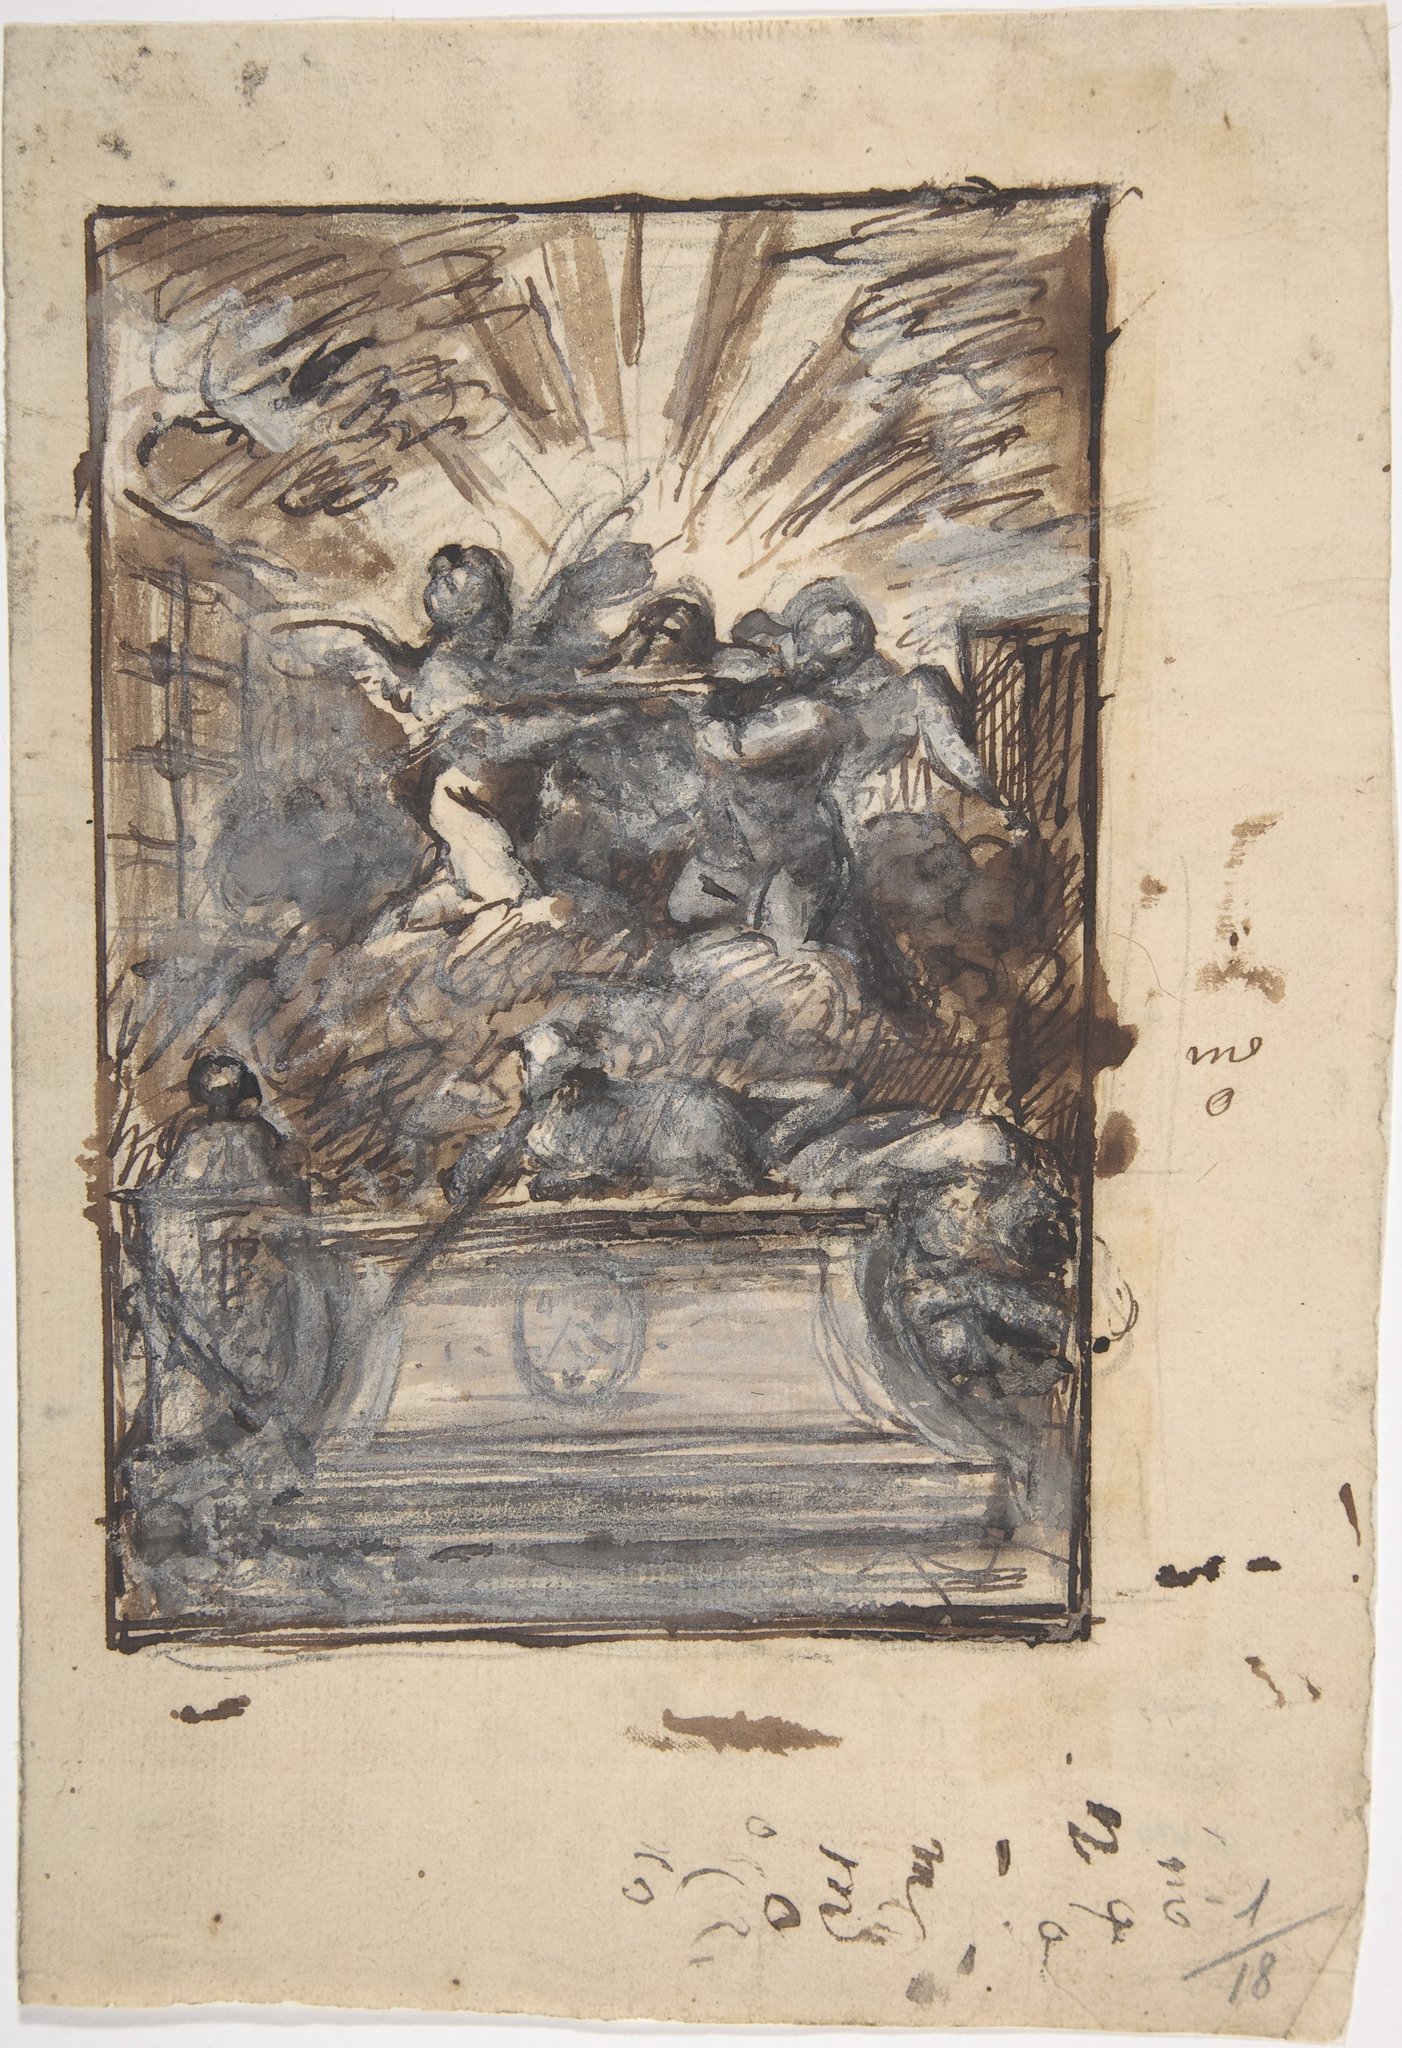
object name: drawing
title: Design for a Monument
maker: gabriel de saint-aubin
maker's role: artist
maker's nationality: french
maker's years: 1724-1780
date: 1701-1800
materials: chalk, ink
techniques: brush, heightening, pen, wash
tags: monuments